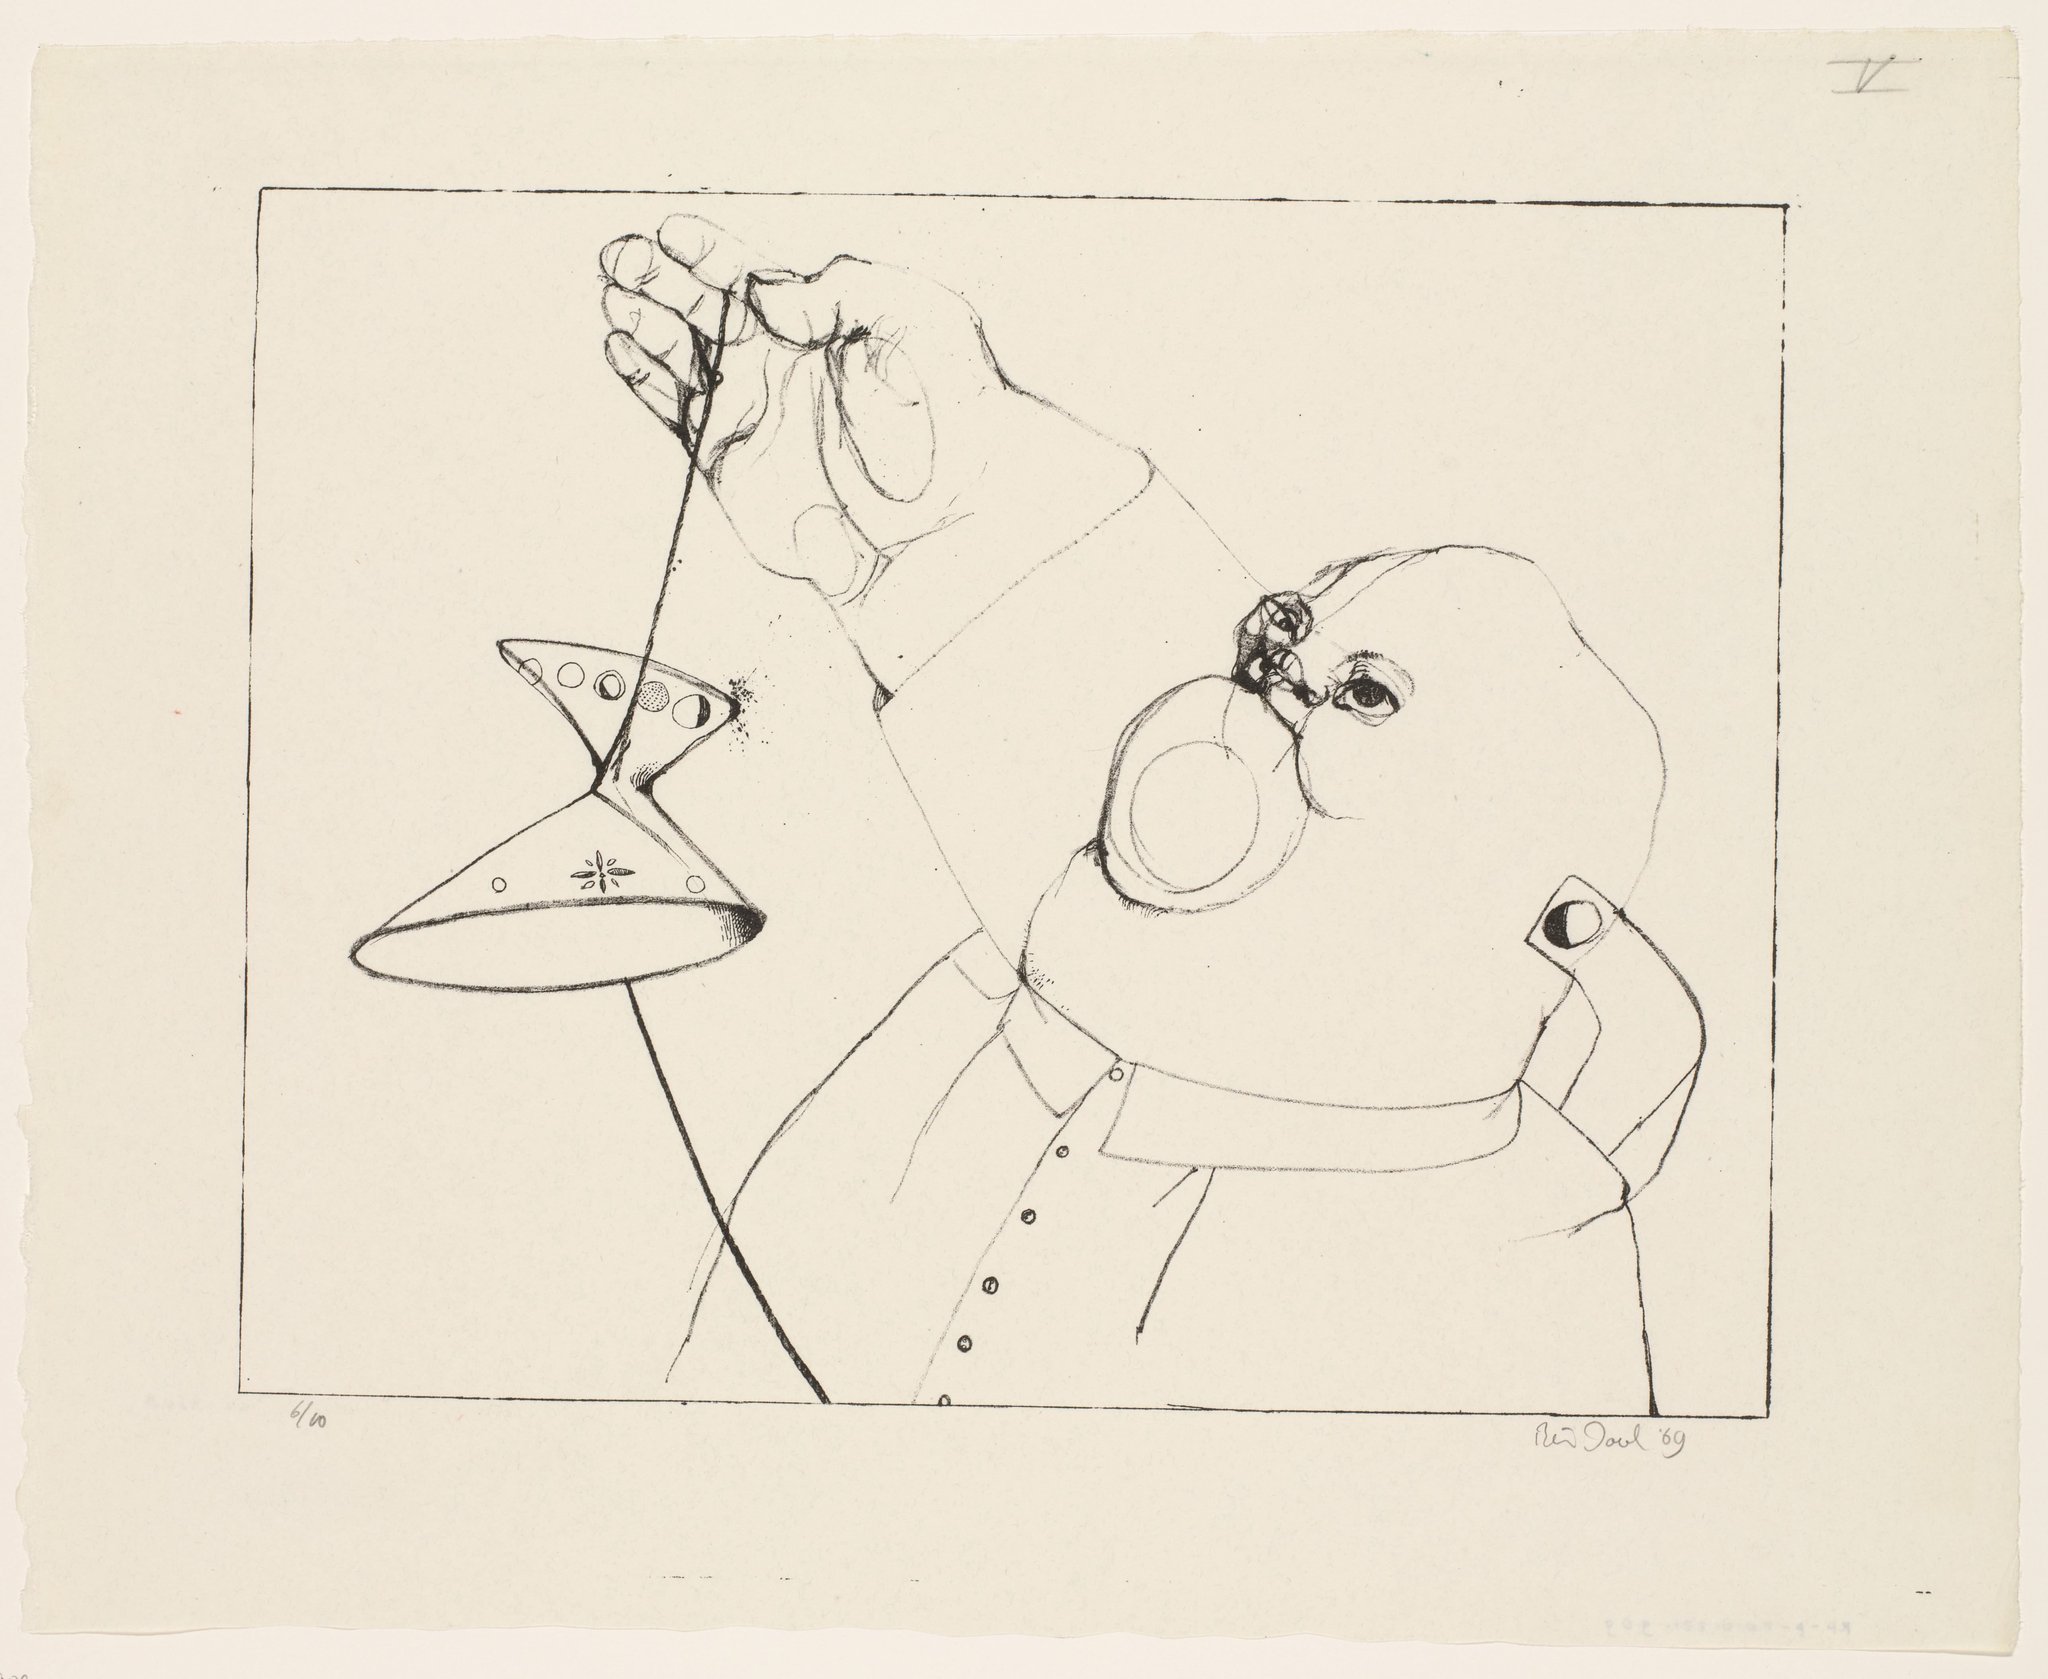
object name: print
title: Litho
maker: rein dool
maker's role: draughtsman, painter, print maker, sculptor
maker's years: 1933-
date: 1969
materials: paper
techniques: lithograph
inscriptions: signature and date: ‘Rein Dool '69’, edition: ‘6/10’